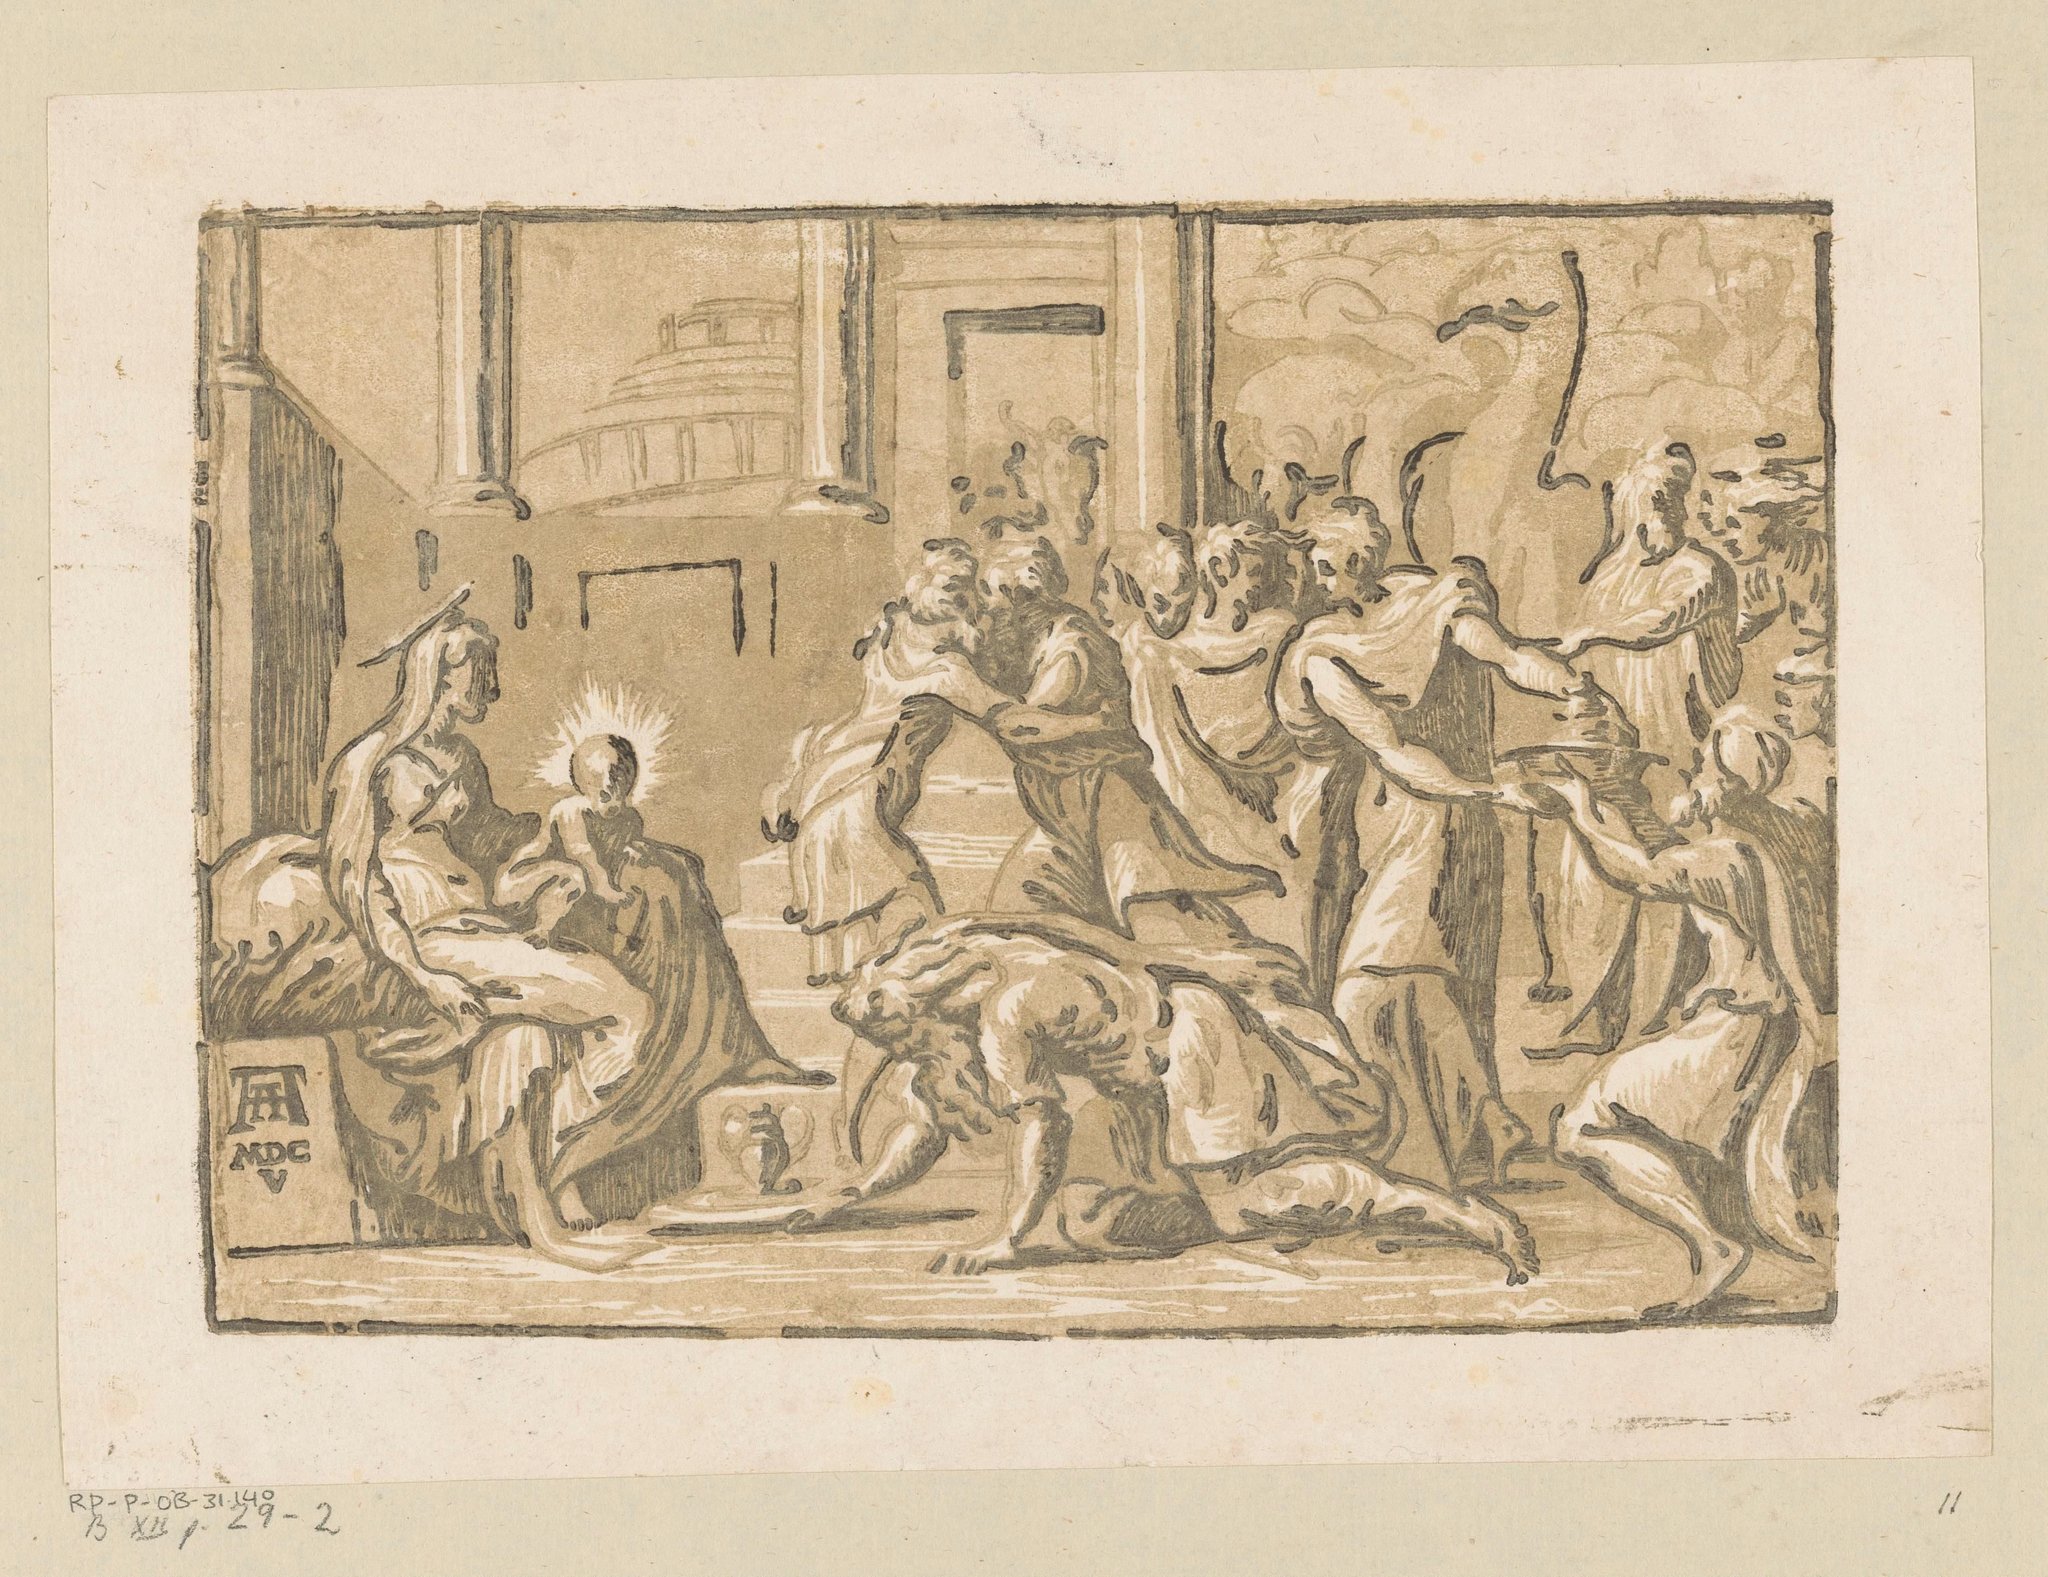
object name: print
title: Aanbidding door de koningen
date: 1605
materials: paper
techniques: woodcut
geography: italy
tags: hoofed animals: camel, adoration of the kings: the wise men present their gifts to the christ-child (gold, frankincense and myrrh)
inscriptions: collector's mark: Lugt 240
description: Links zit Maria met het Christuskind. De koningen bieden geschenken aan en achter hen staat een kameel.